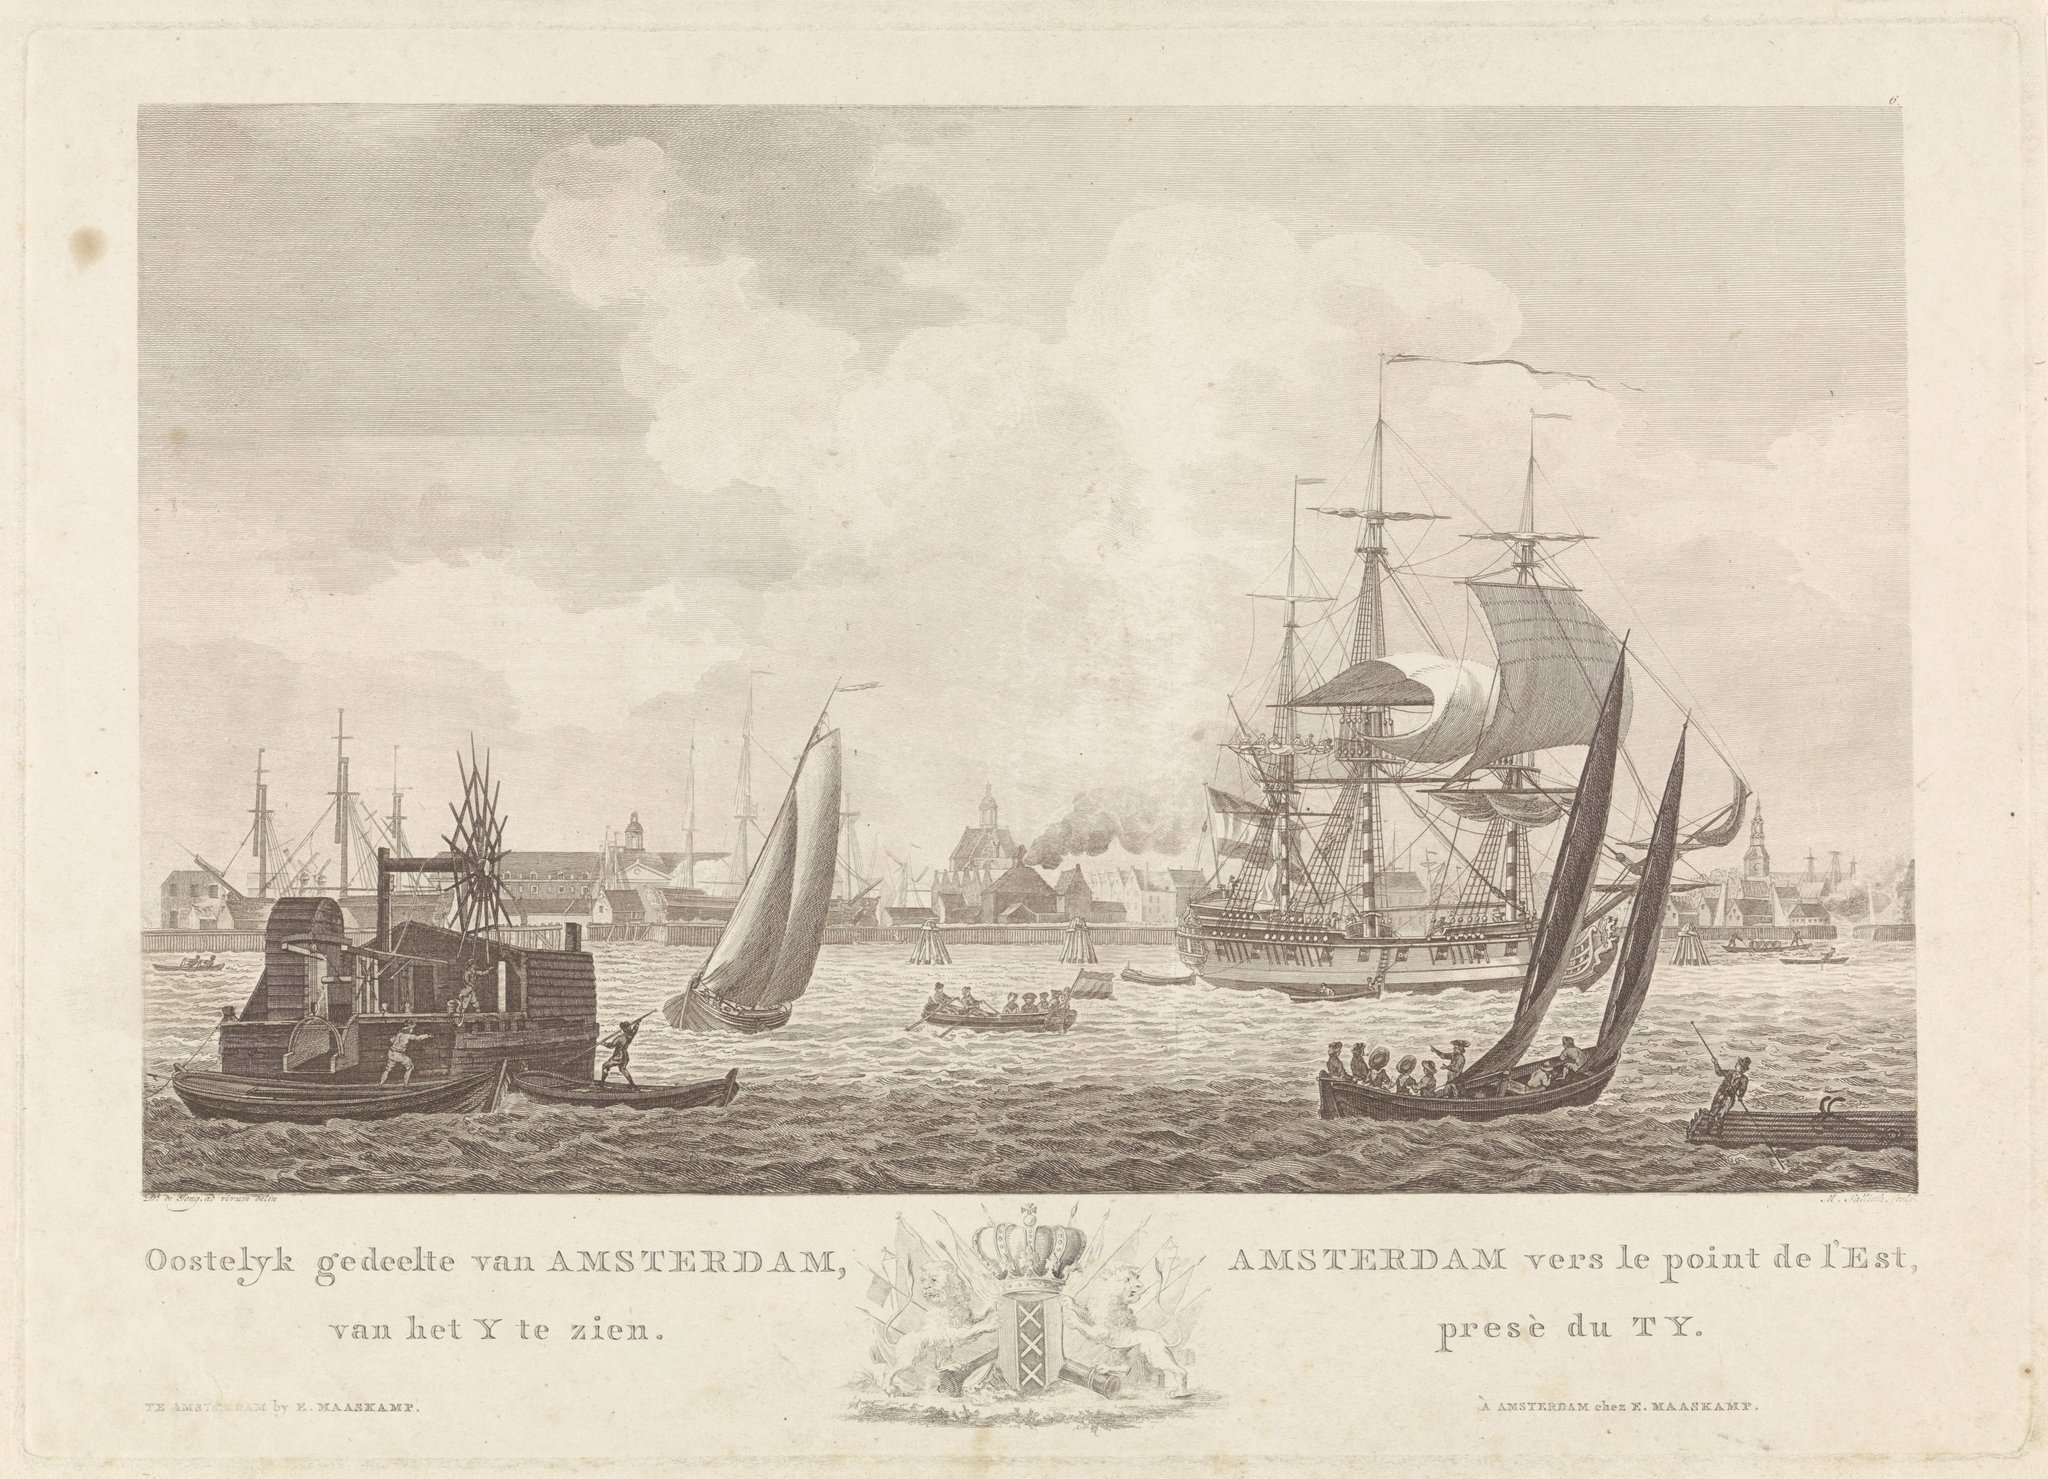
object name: print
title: Oostelyk gedeelte van Amsterdam, van het Y te zien / Amsterdam vers le point de l'Est, presè du TY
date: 1805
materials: paper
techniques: engraving, etching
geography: amsterdam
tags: coat of arms (as symbol of the state, etc.) (+ city; municipal), sailing-ship, sailing-boat, rowing-boat, canoe, etc., prospect of city, town panorama, silhouette of city, amsterdam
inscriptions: collector's mark: Lugt 2228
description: Huidige staat van prent ook gebruikt in: Aa, Cornelis van der. Atlas van de zeehavens der Bataafsche Republiek. Met derzelver beschrijvingen in XXXI kunstplaaten / Atlas van de zeehavens der Bataafsche Republiek, die van Batavia en Onrust. Mitsgaders de afbeeldingen van de haringvisscherij en de walvischvangst (…). Amsterdam: Evert Maaskamp, 1805. En in: Nieuwe atlas, van de voornaamste gebouwen en gezigten der stad Amsterdam. Met derzelver beknopte beschryvingen. Amsterdam: Evert Maaskamp, 1805. Zie RP-P-AO-20-80E en RP-P-1905-763 voor eerdere staat.